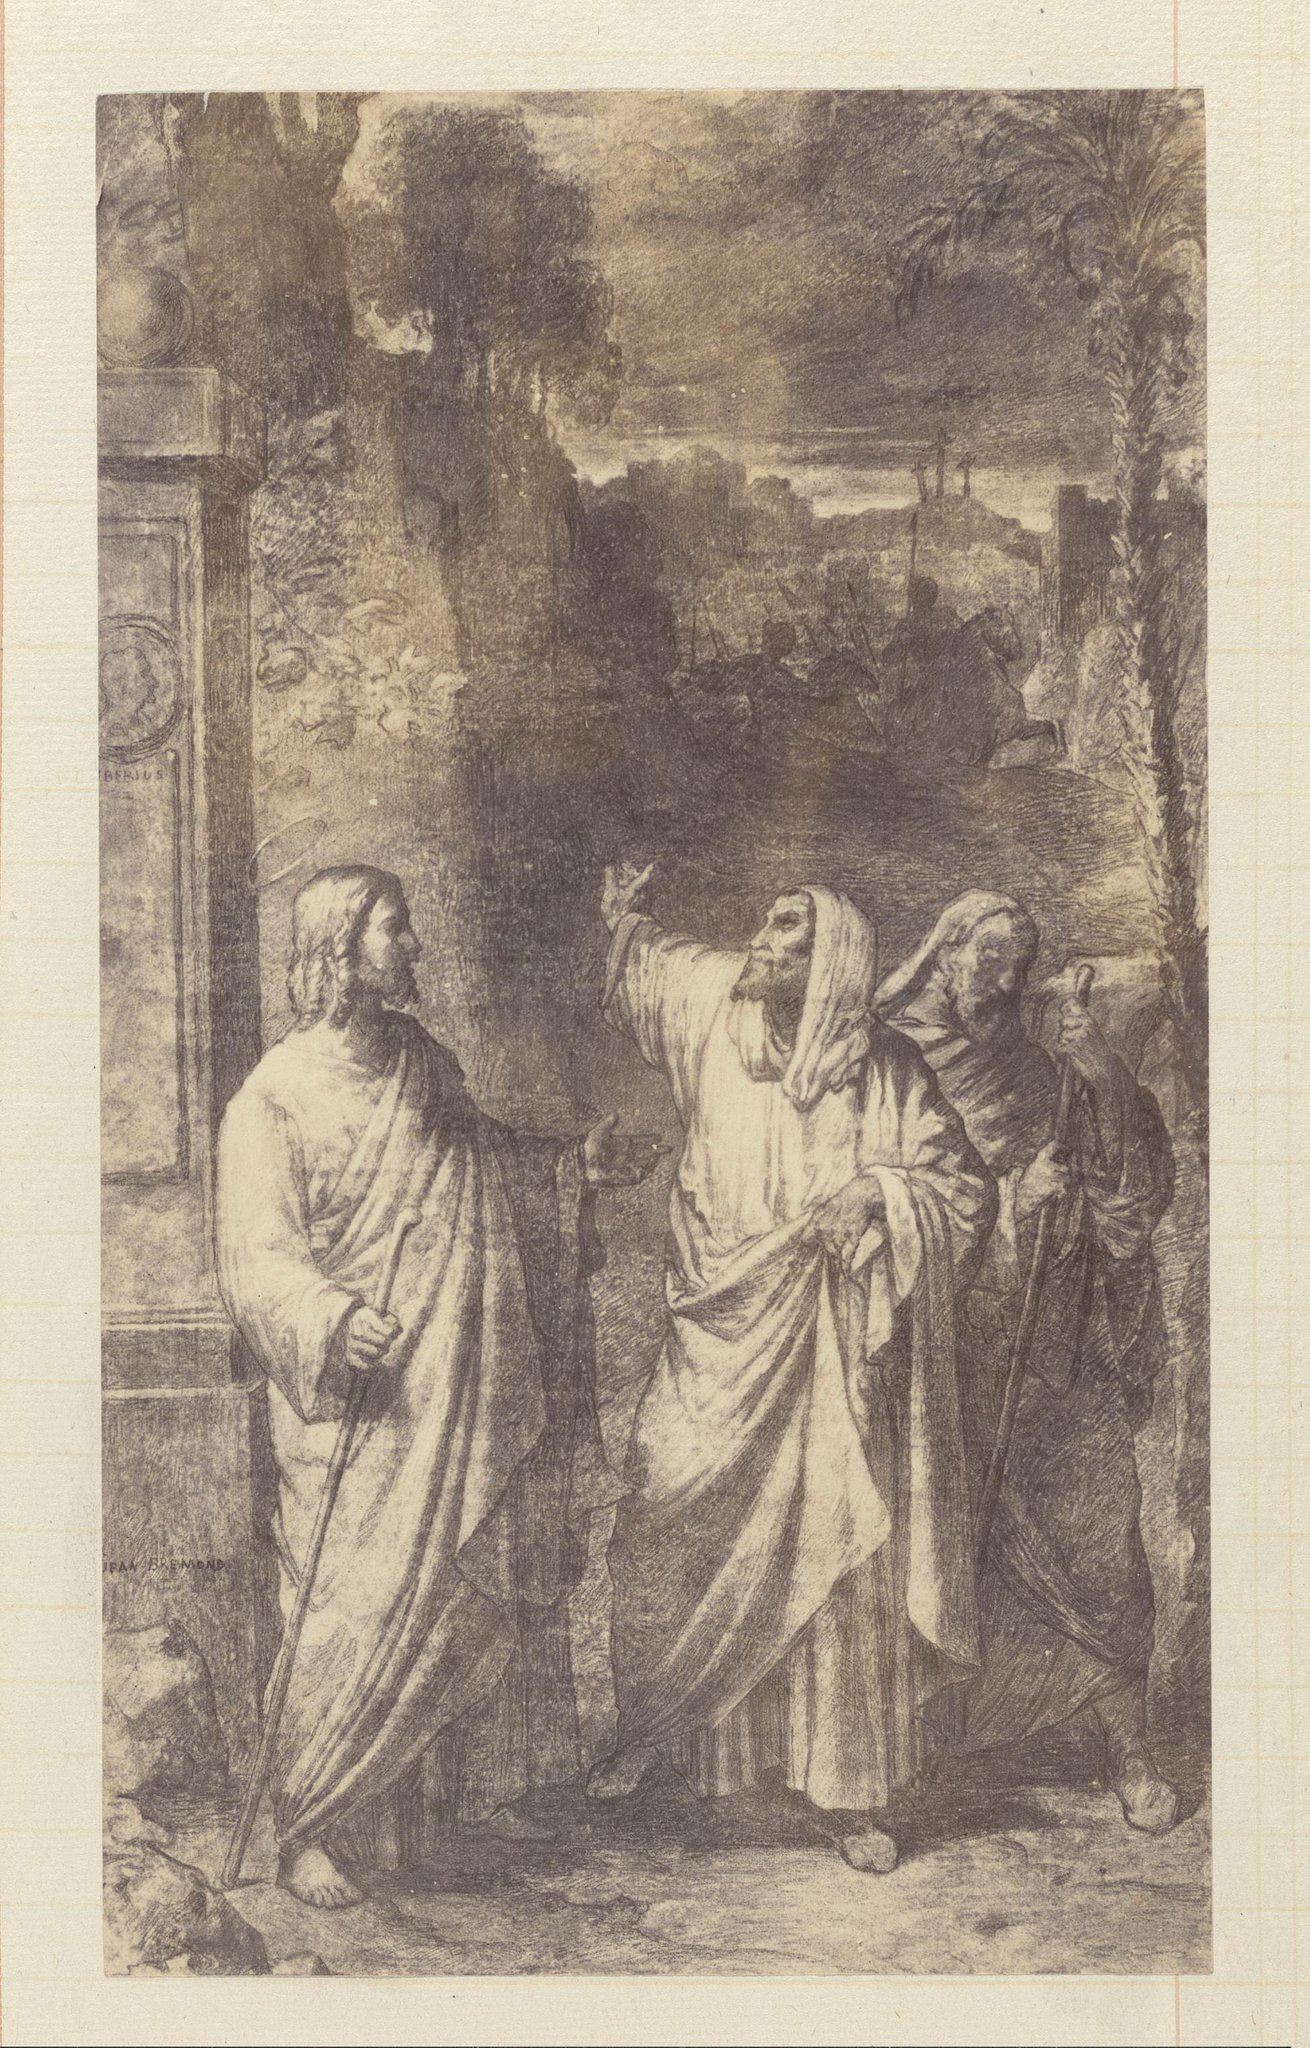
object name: photograph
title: Fotoreproductie van (vermoedelijk) een tekening gesigneerd door 'Jean Bremond', voorstellend Christus en discipelen in de Hof van Olijven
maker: jean-françois brémond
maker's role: painter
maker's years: 1807-1868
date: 1880-1900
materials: paper, photographic support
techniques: albumen print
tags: the arrest of christ ~ garden of gethsemane